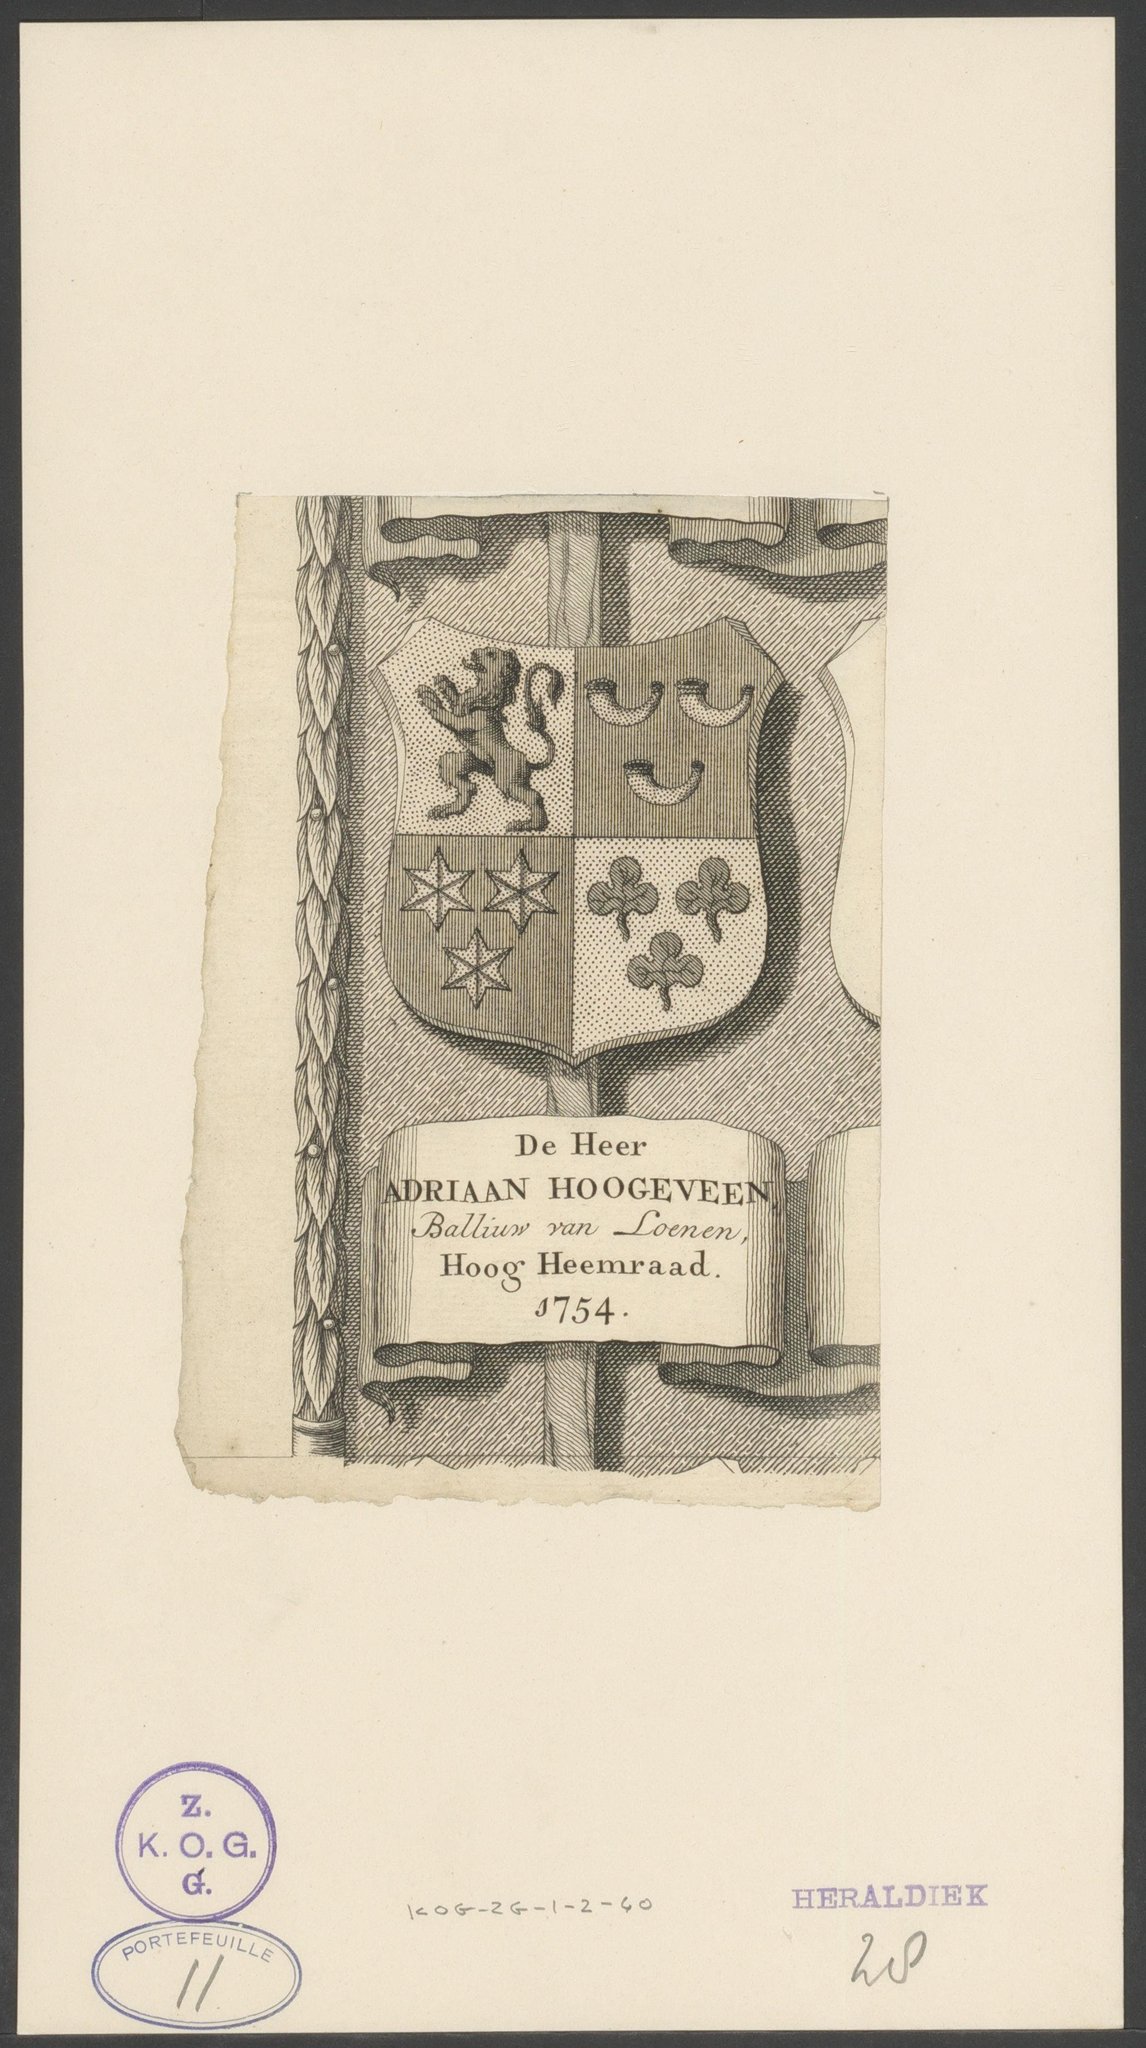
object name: print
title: Familiewapen van Adriaan Hoogeveen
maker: Anonymous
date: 1754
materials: paper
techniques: etching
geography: netherlands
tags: armorial bearing, heraldry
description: Familiewapen van Adriaan Hoogeveen, baljuw van Loenen, Hoog Heemraad 1754. Waarschijnlijk deel van de wapenrand van een kaart van een Hoogheemraadschap (van Rijnland?). Onderwerpsrubrieken binnen de Atlas Zeden en Gewoonten: Regeering, Wapens (Heraldiek), Geslachtswapens.